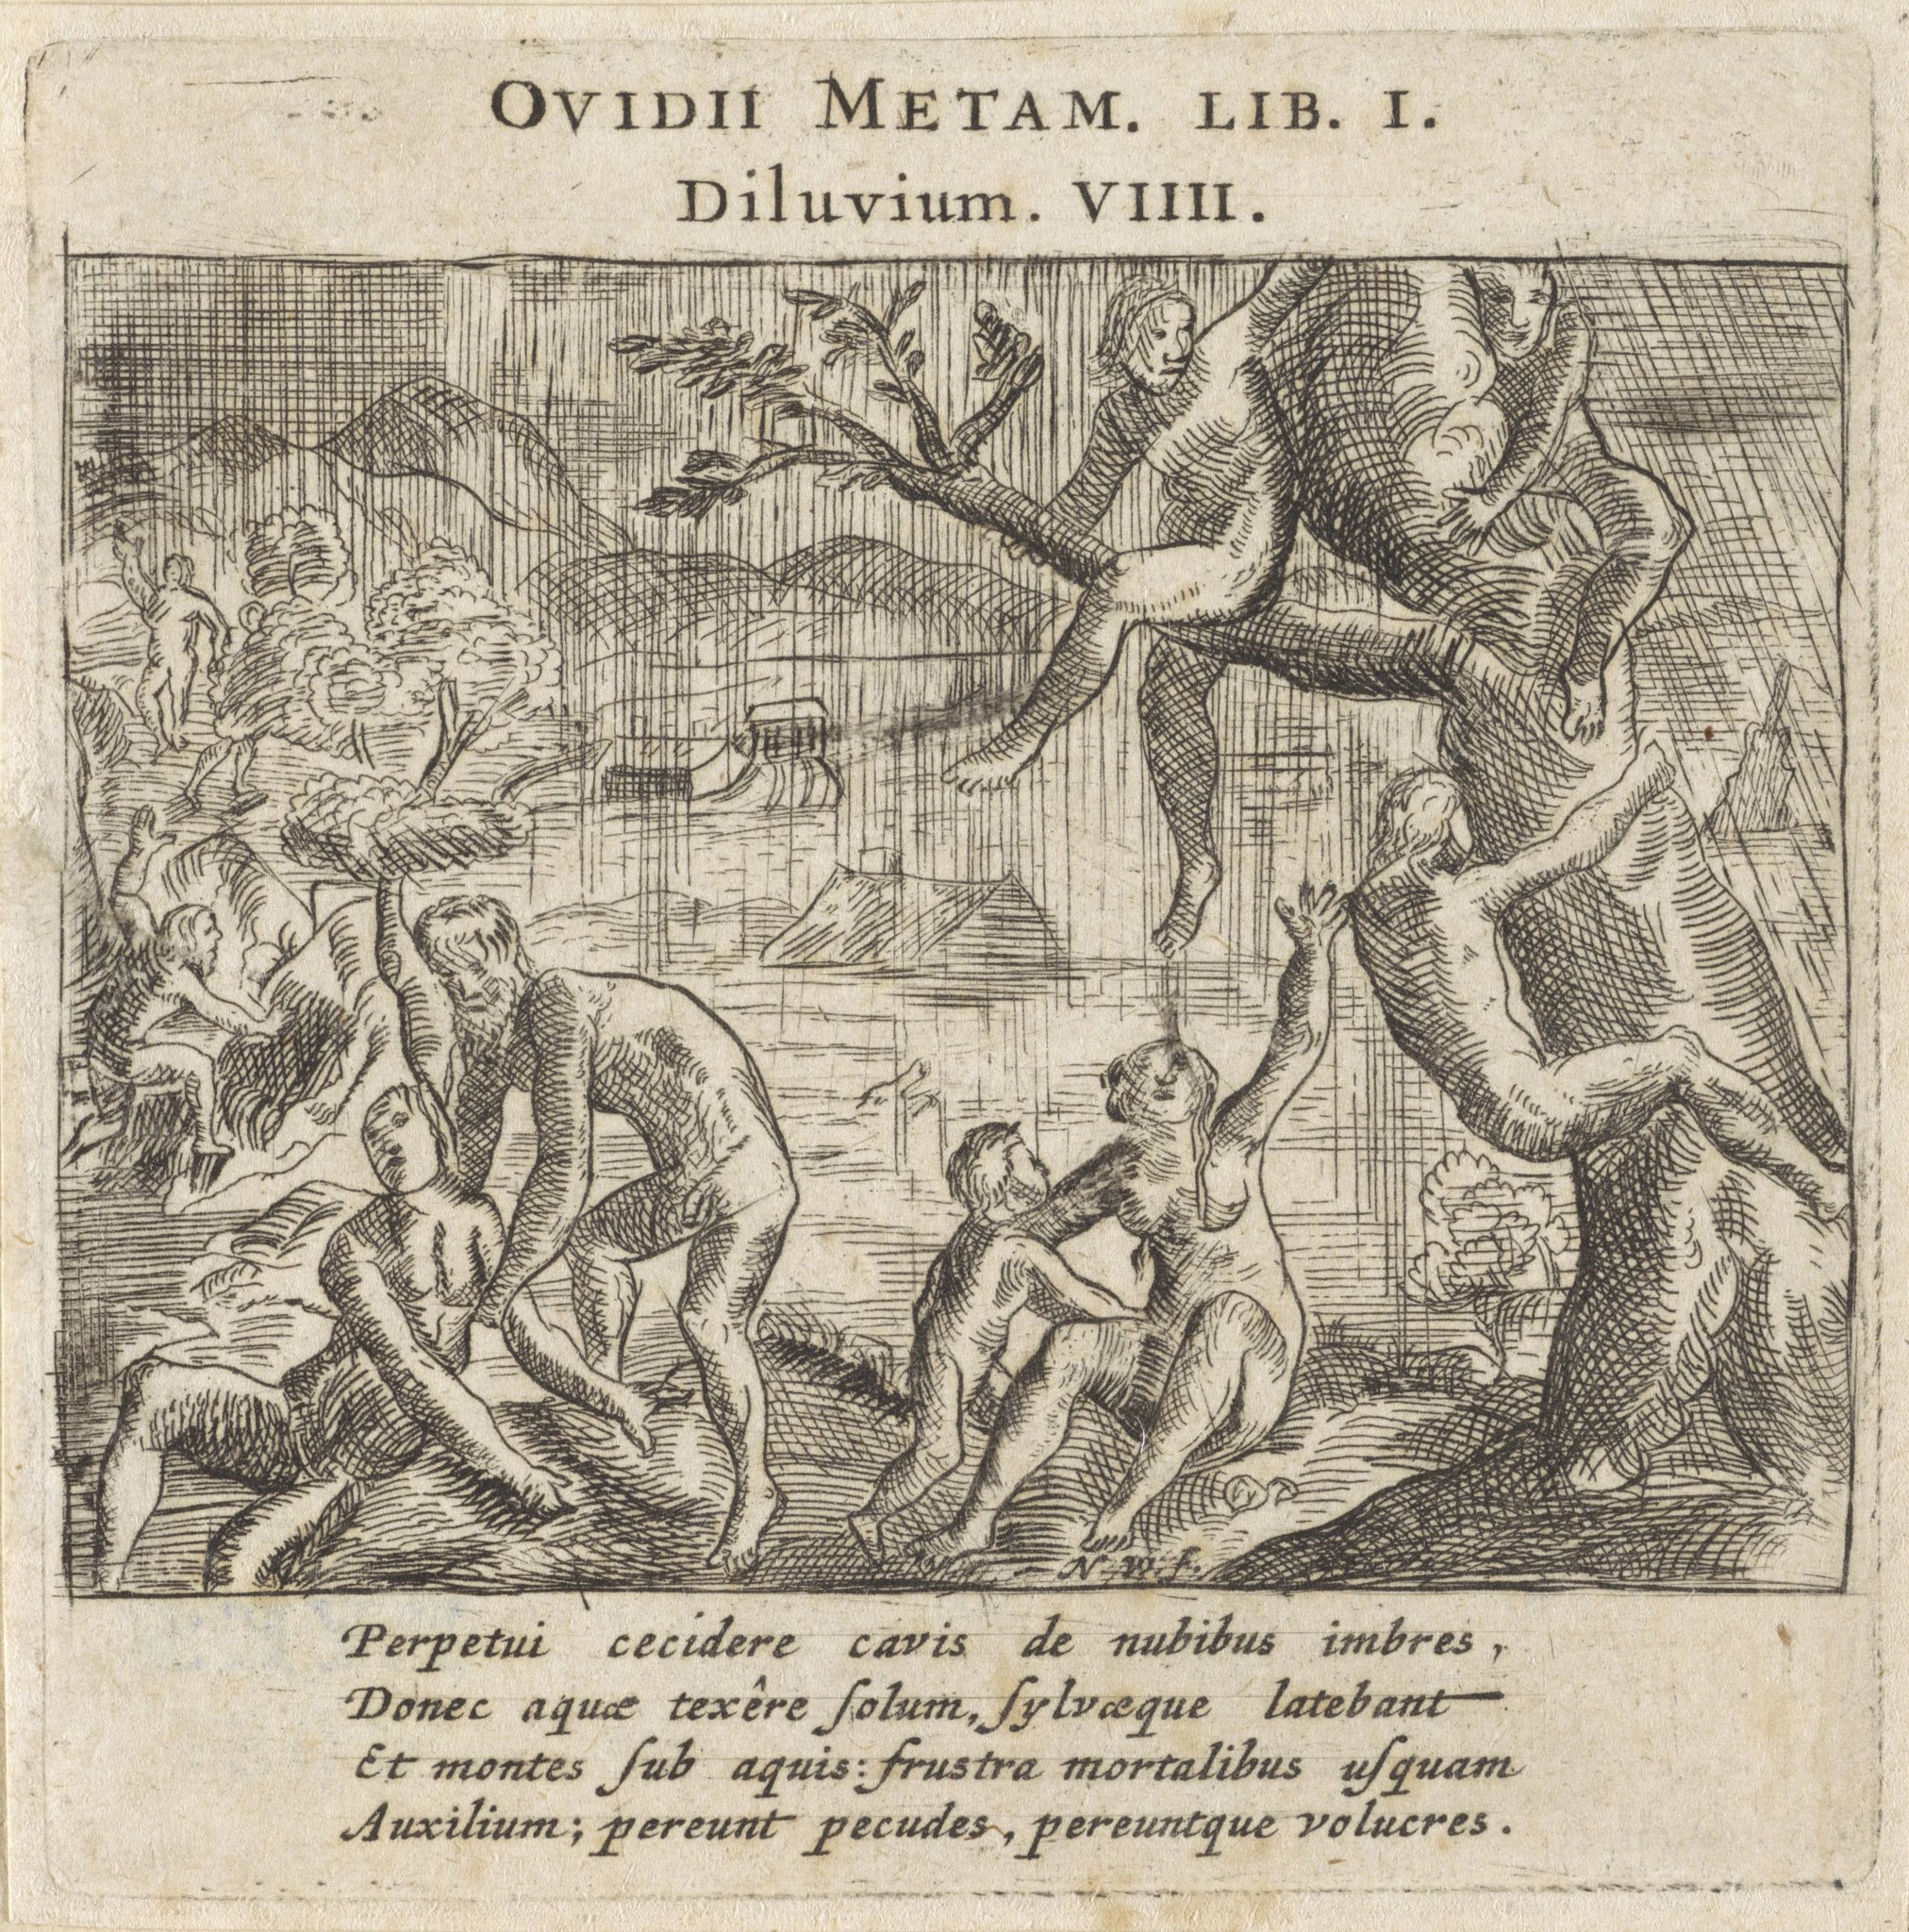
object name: print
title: Scènes uit het eerste boek van Ovidius' Metamorphosen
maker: nicolaes cornelisz. witsen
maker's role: mayor, print maker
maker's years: 1641-1717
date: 1659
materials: paper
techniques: etching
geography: amsterdam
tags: deucalion's flood; jupiter sends a great flood to destroy mankind; deucalion and pyrrha afloat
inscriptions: collector's mark: Lugt 2165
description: Naakte mensen vluchten voor het stijgende water van de zondvloed die door Jupiter is gestuurd. Onder de voorstelling een vierregelige toelichting in het Latijn.